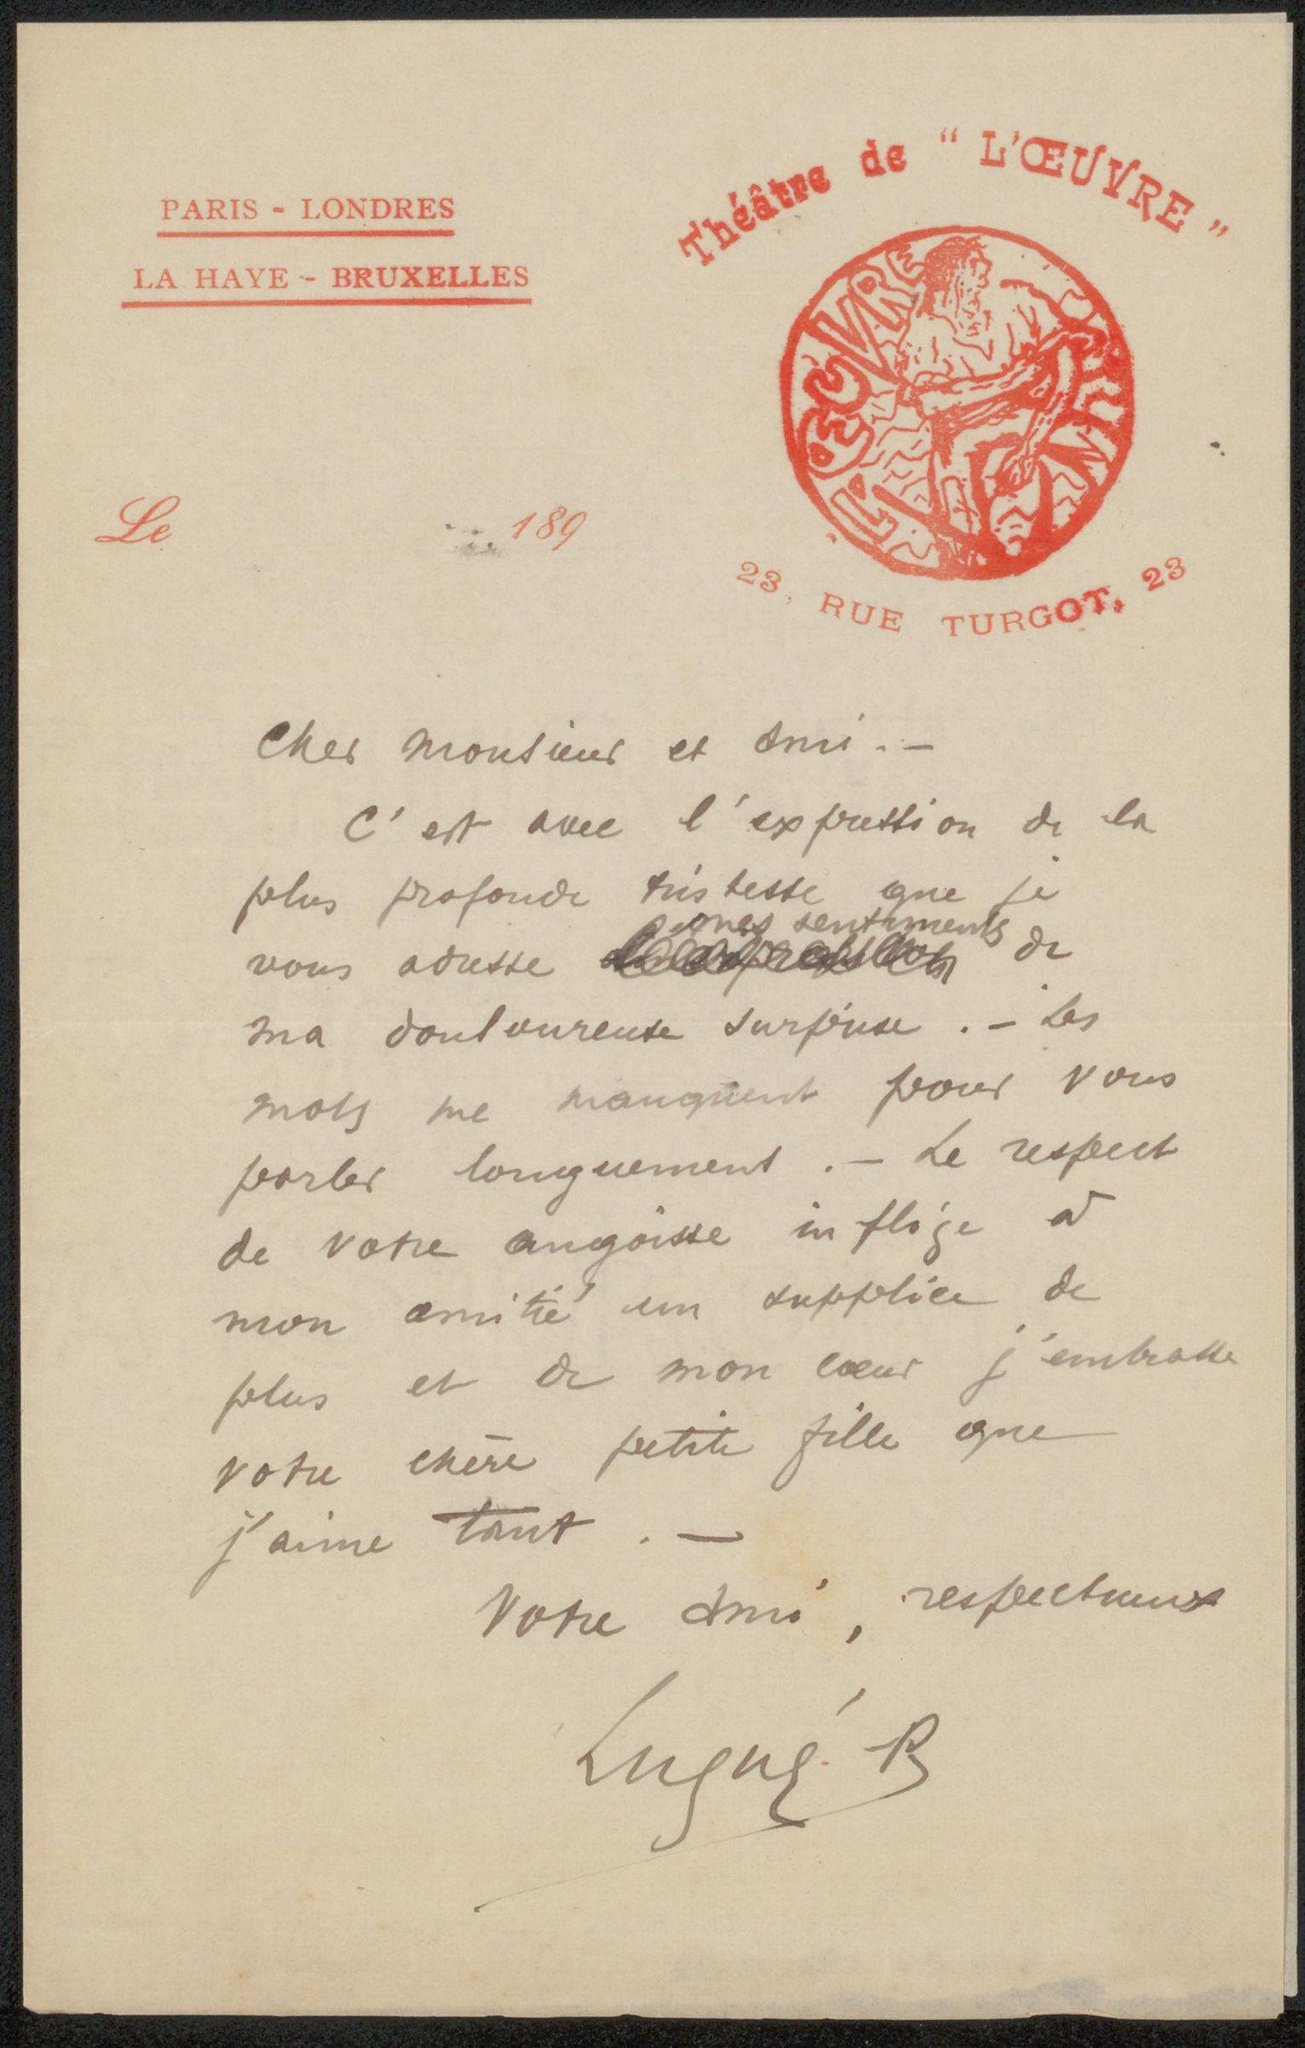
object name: letter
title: Brief aan Philip Zilcken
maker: lugné-poe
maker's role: acteur, theaterdirecteur, theatervormgever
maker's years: 1869-1940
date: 1811-1895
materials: ink, paper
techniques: pen, printing, writing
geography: paris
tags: renée hélène laure zilcken, brussels, helène lambertine hauzeur, the hague, painter, draughtsman, philip zilcken, passions, emotions, affections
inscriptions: name